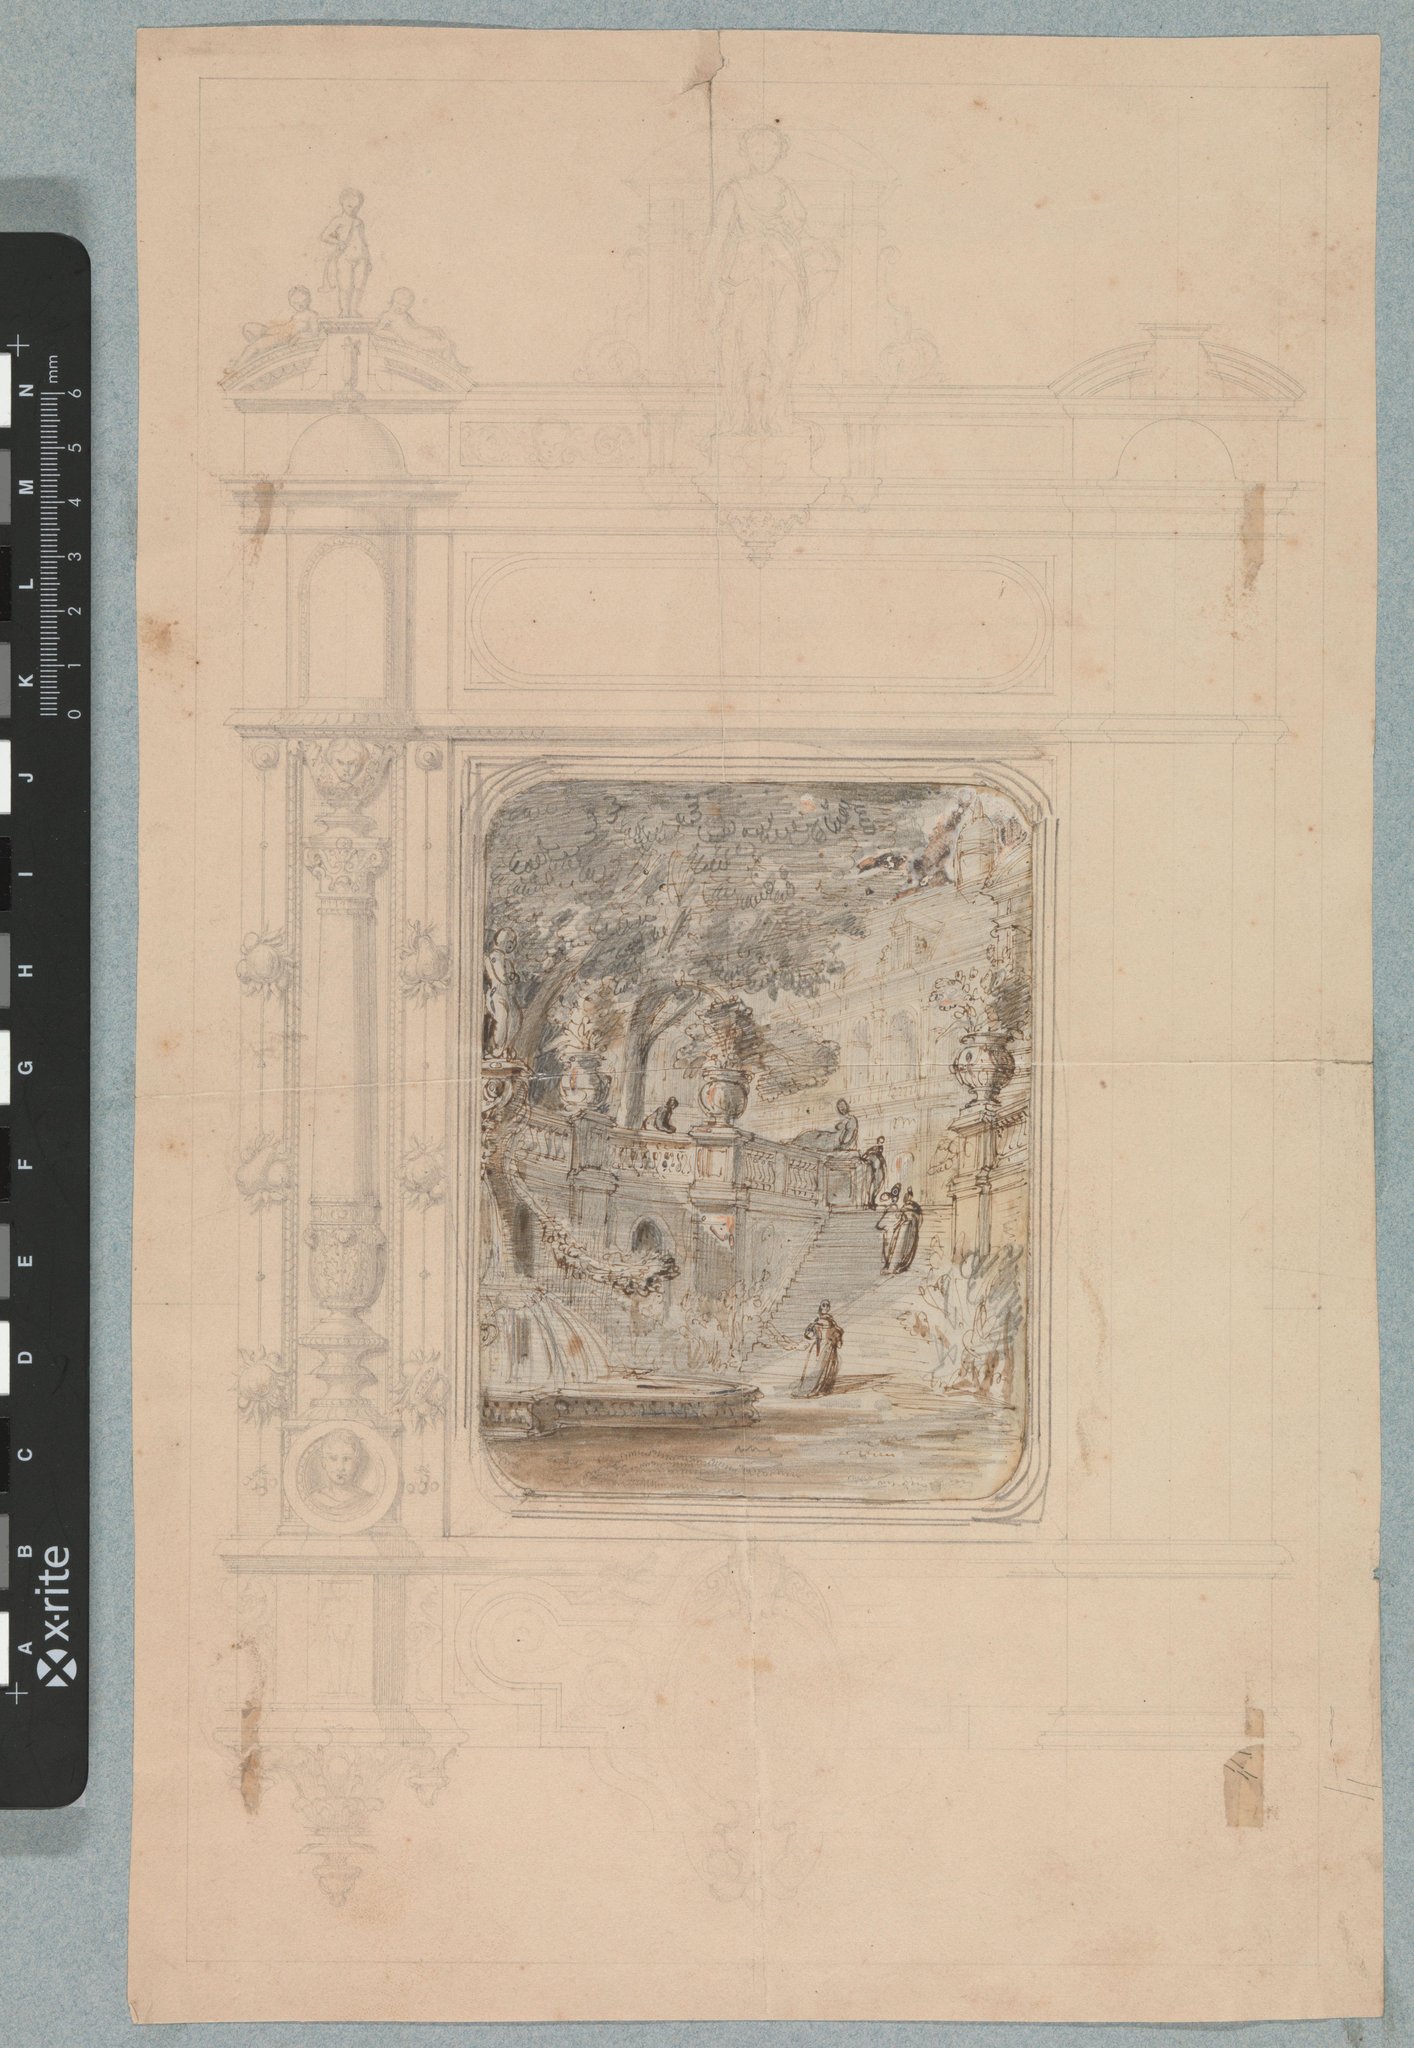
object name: design drawing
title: Door figuren bekroonde lijst in renaissance-stijl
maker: henri cameré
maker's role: designer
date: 1864-1894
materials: paint, ink, pencil, paper, watercolor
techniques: brush, pen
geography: paris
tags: garden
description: In het midden van de lijst een rechthoekige opening met afgeronde hoeken, waarin is gemonteerd een landschap met een grote trap met balustrades bij een fontein, die naar een gebouw leidt en die door enkele figuren wordt bestegen.